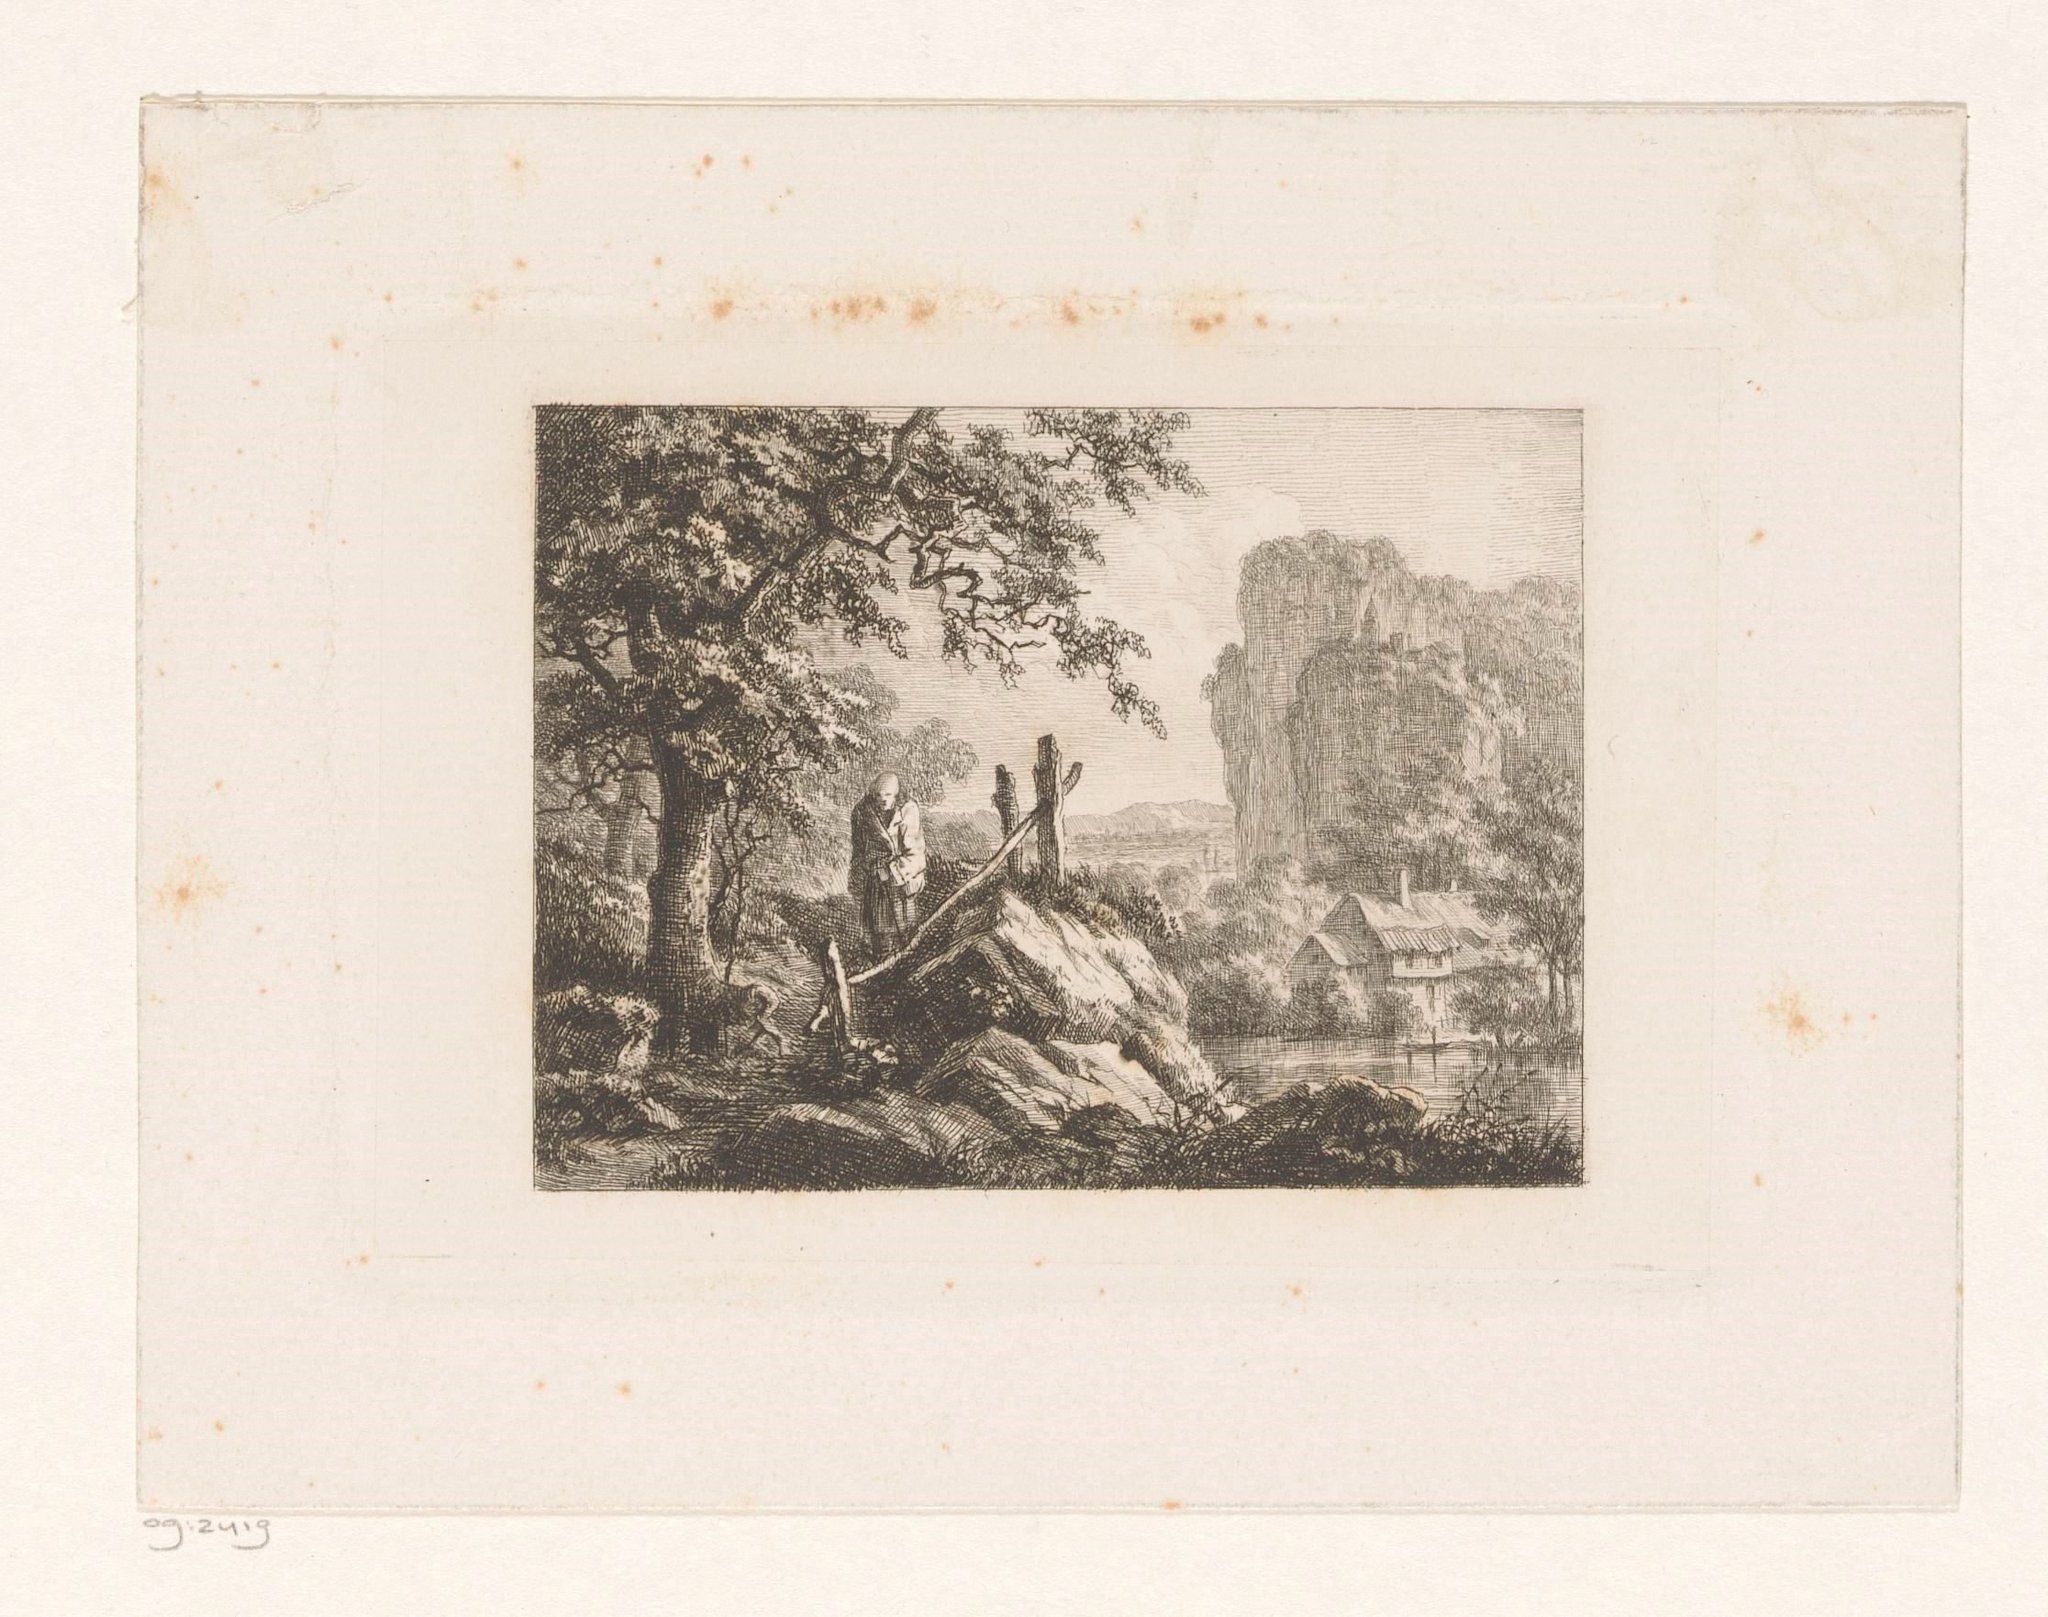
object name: print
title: Bergachtig landschap met links een wandelaar naast een hek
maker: joseph hubert blees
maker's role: print maker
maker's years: 1826-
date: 1861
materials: paper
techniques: etching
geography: cleves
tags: 'en route', traveller under way, mountains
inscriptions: collector's mark: Lugt 2228